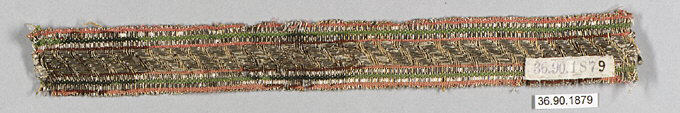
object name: galloon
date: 1801-1900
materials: metal thread, silk